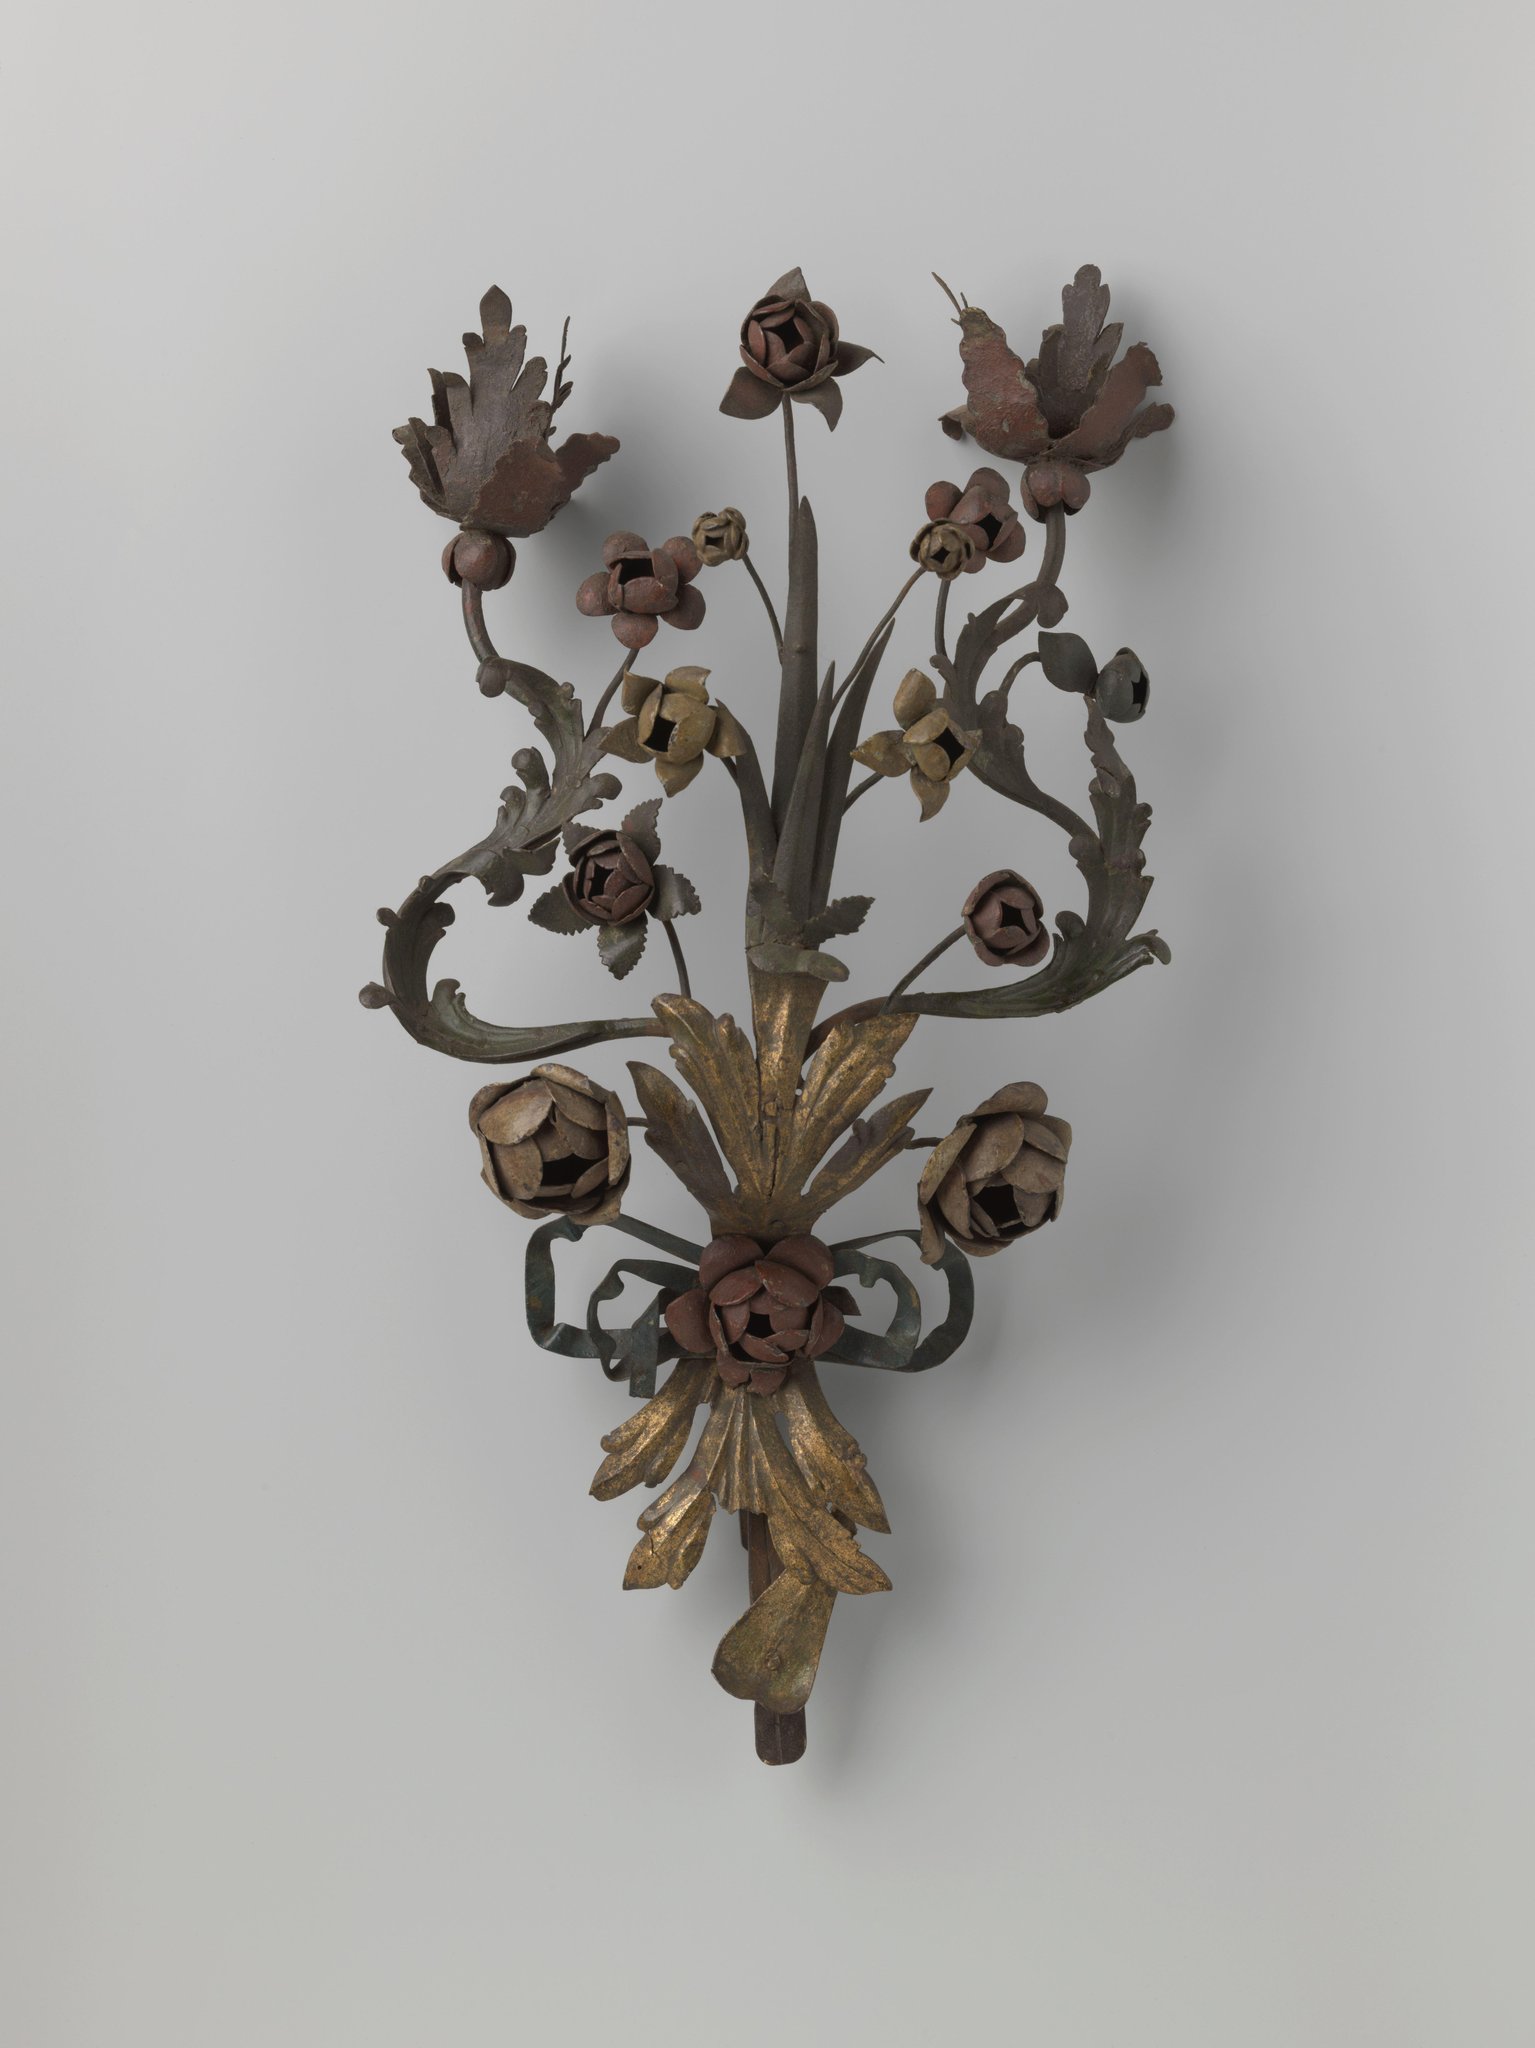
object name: altaarboeket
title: Wandarm, waarvan de armen en de kaarsenhouders zijn vormgegeven als bloemtakken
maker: Anonymous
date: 1700-1750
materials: iron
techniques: forging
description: Een gesmeed ijzer altaarboeket. Met de oorspronkelijke kleuren beschilderd.